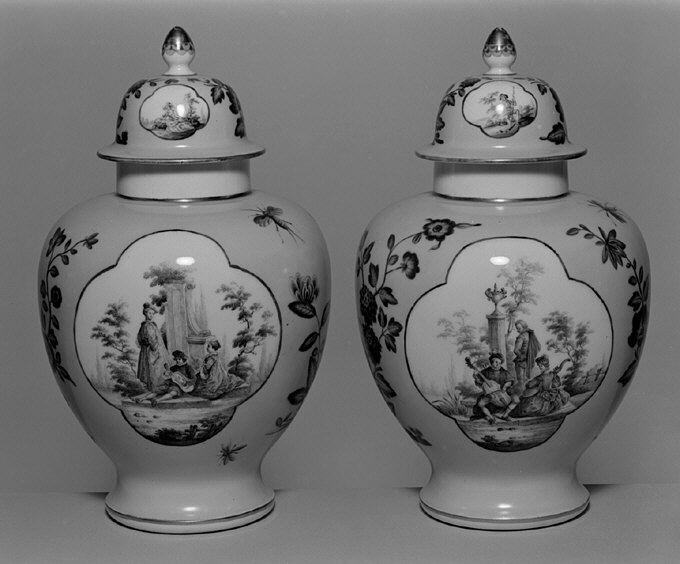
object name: vase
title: Vase (one of a pair)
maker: meissen manufactory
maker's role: manufactory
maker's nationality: german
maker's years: 1710-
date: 1740-1745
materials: hard paste porcelain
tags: men,cellos,flowers